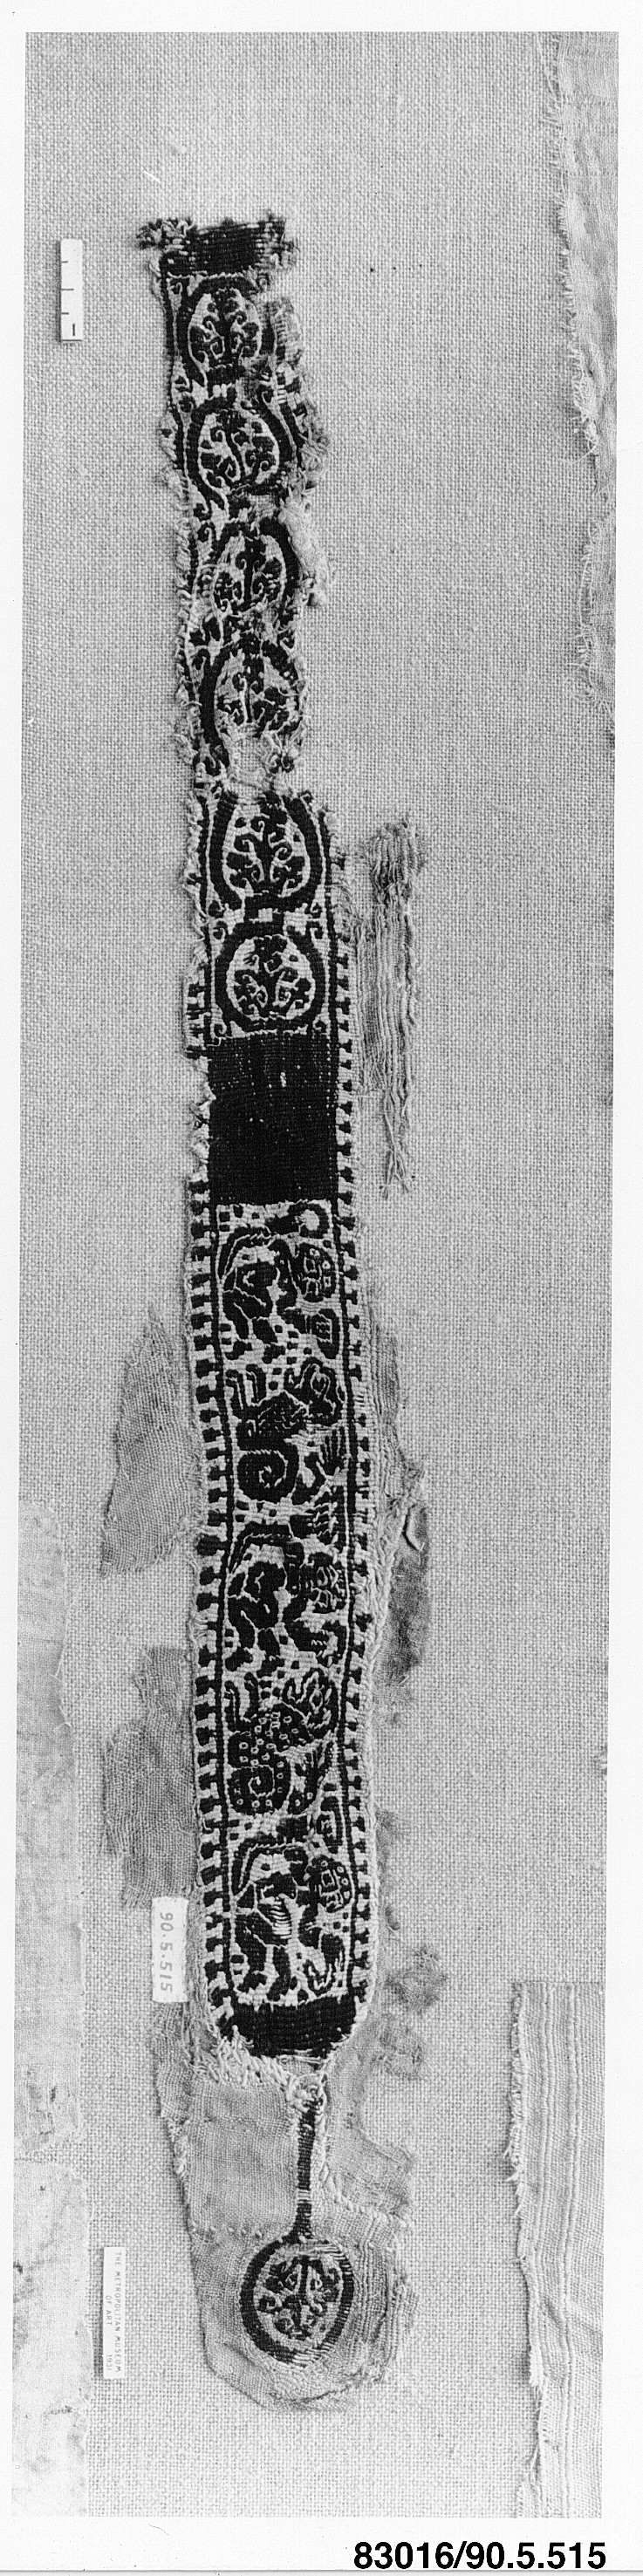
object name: textile fragment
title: Fragment of Shoulder Band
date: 201-400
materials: linen, wool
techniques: weave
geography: egypt